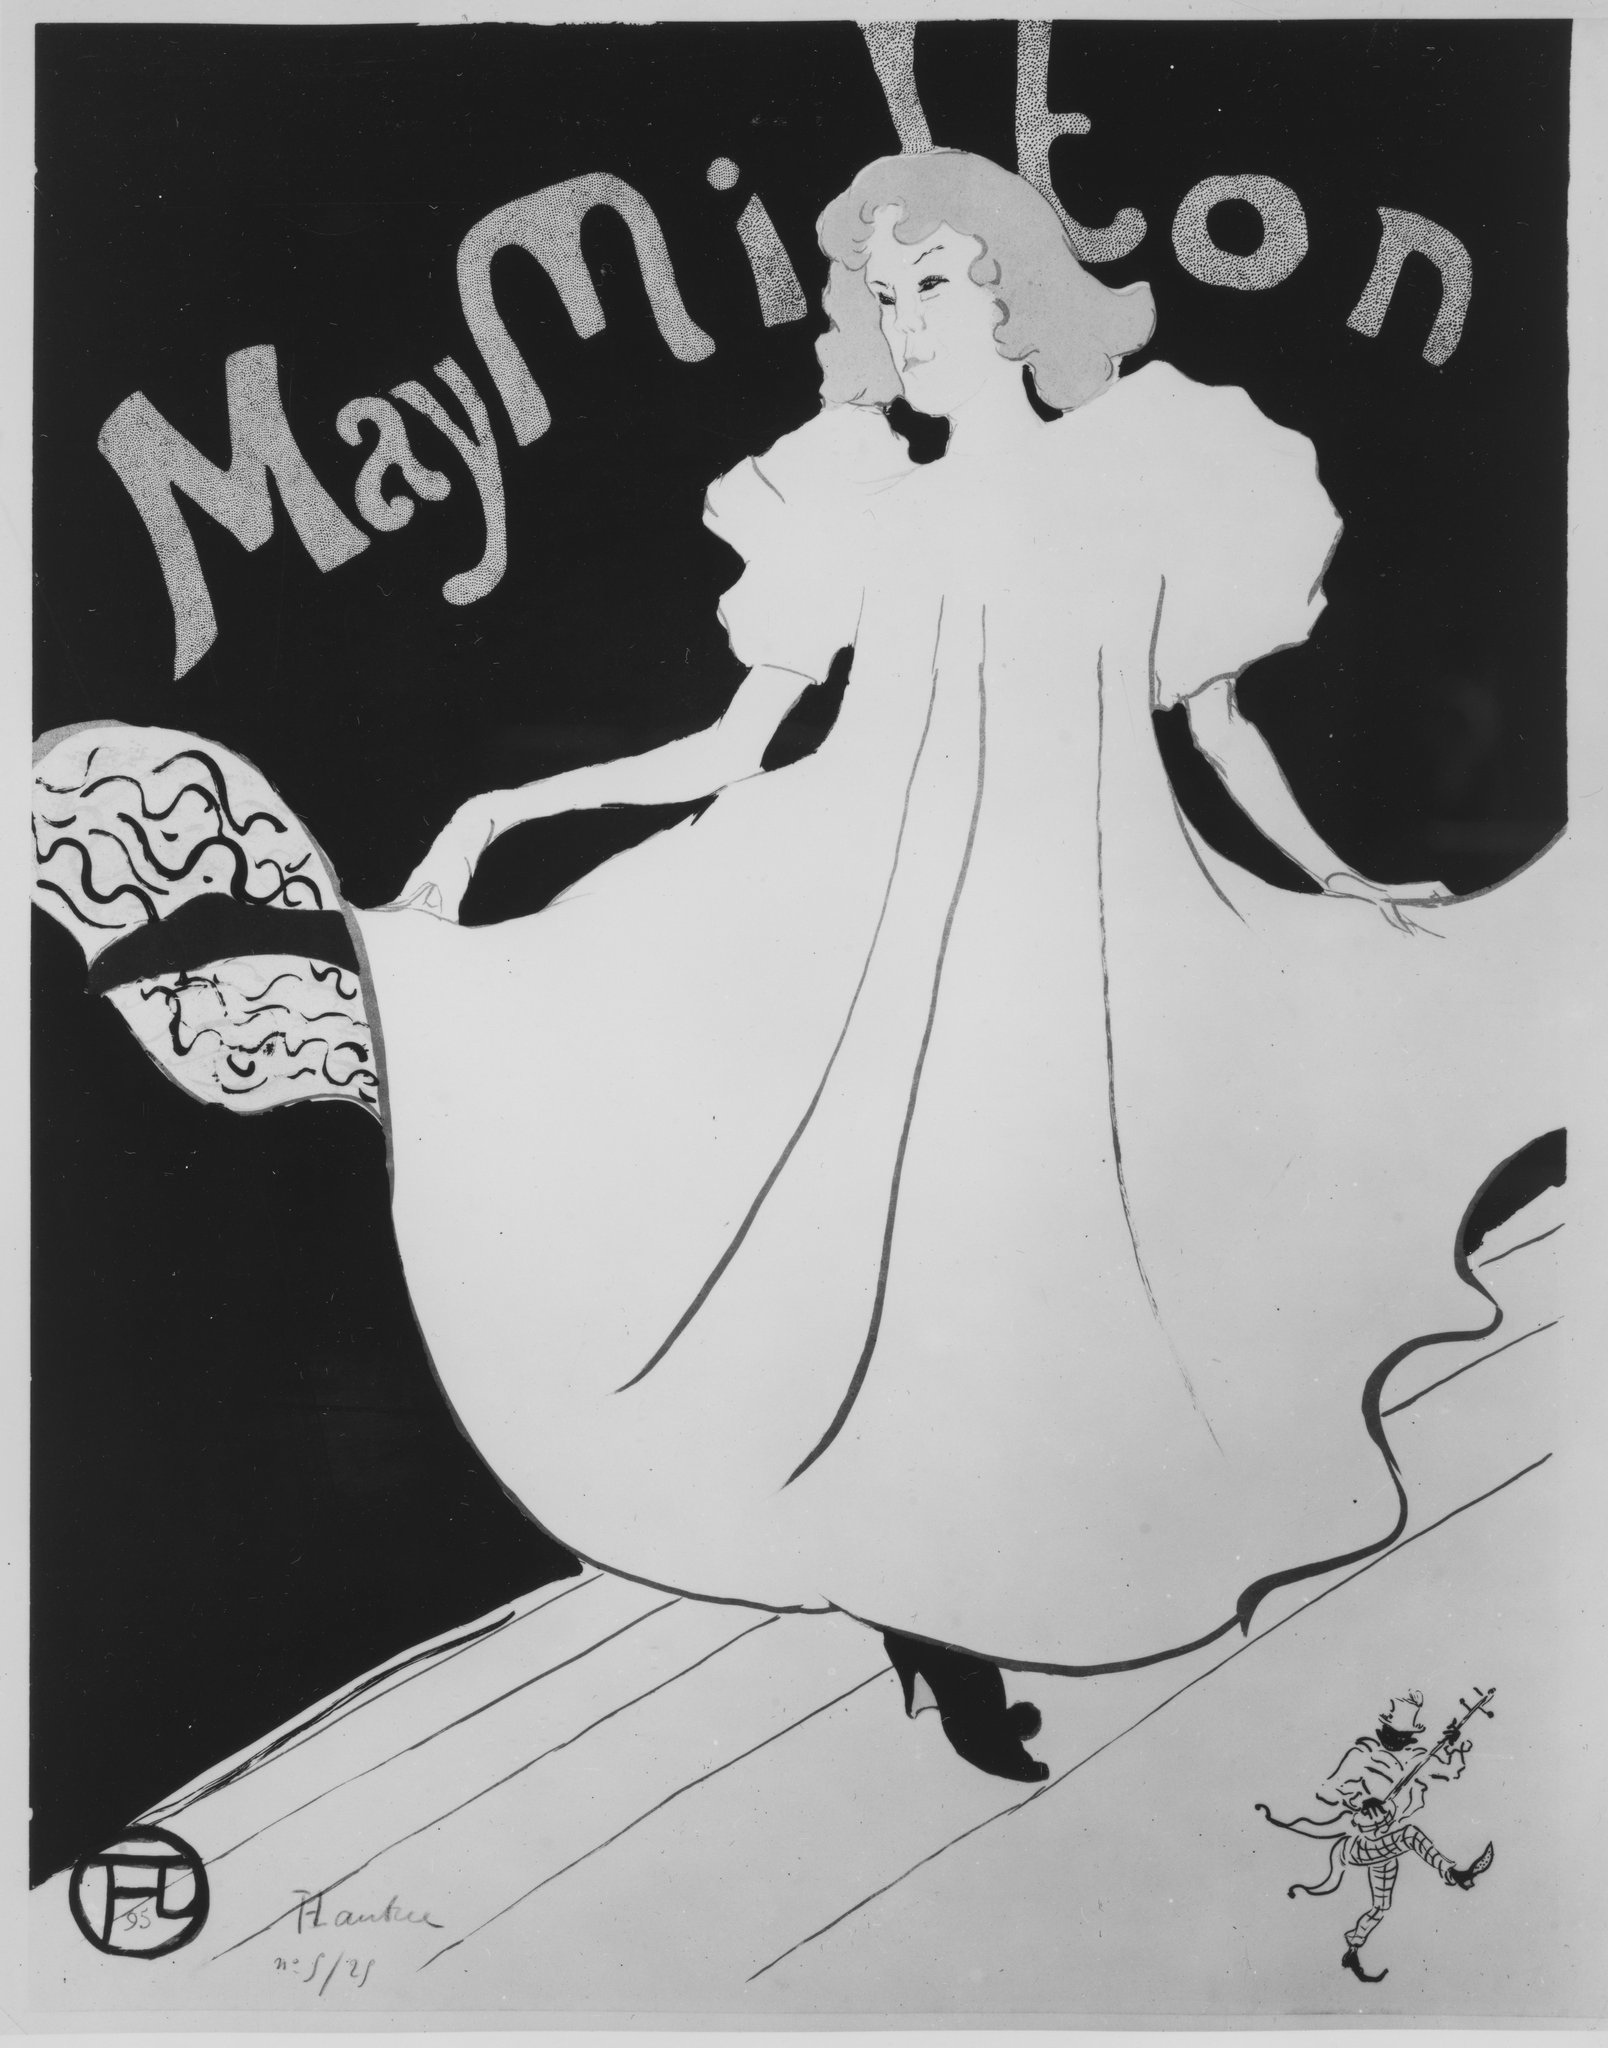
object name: print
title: May Milton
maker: henri de toulouse-lautrec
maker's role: artist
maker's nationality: french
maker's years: 1864-1901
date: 1895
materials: paper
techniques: lithograph, printing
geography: france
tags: women